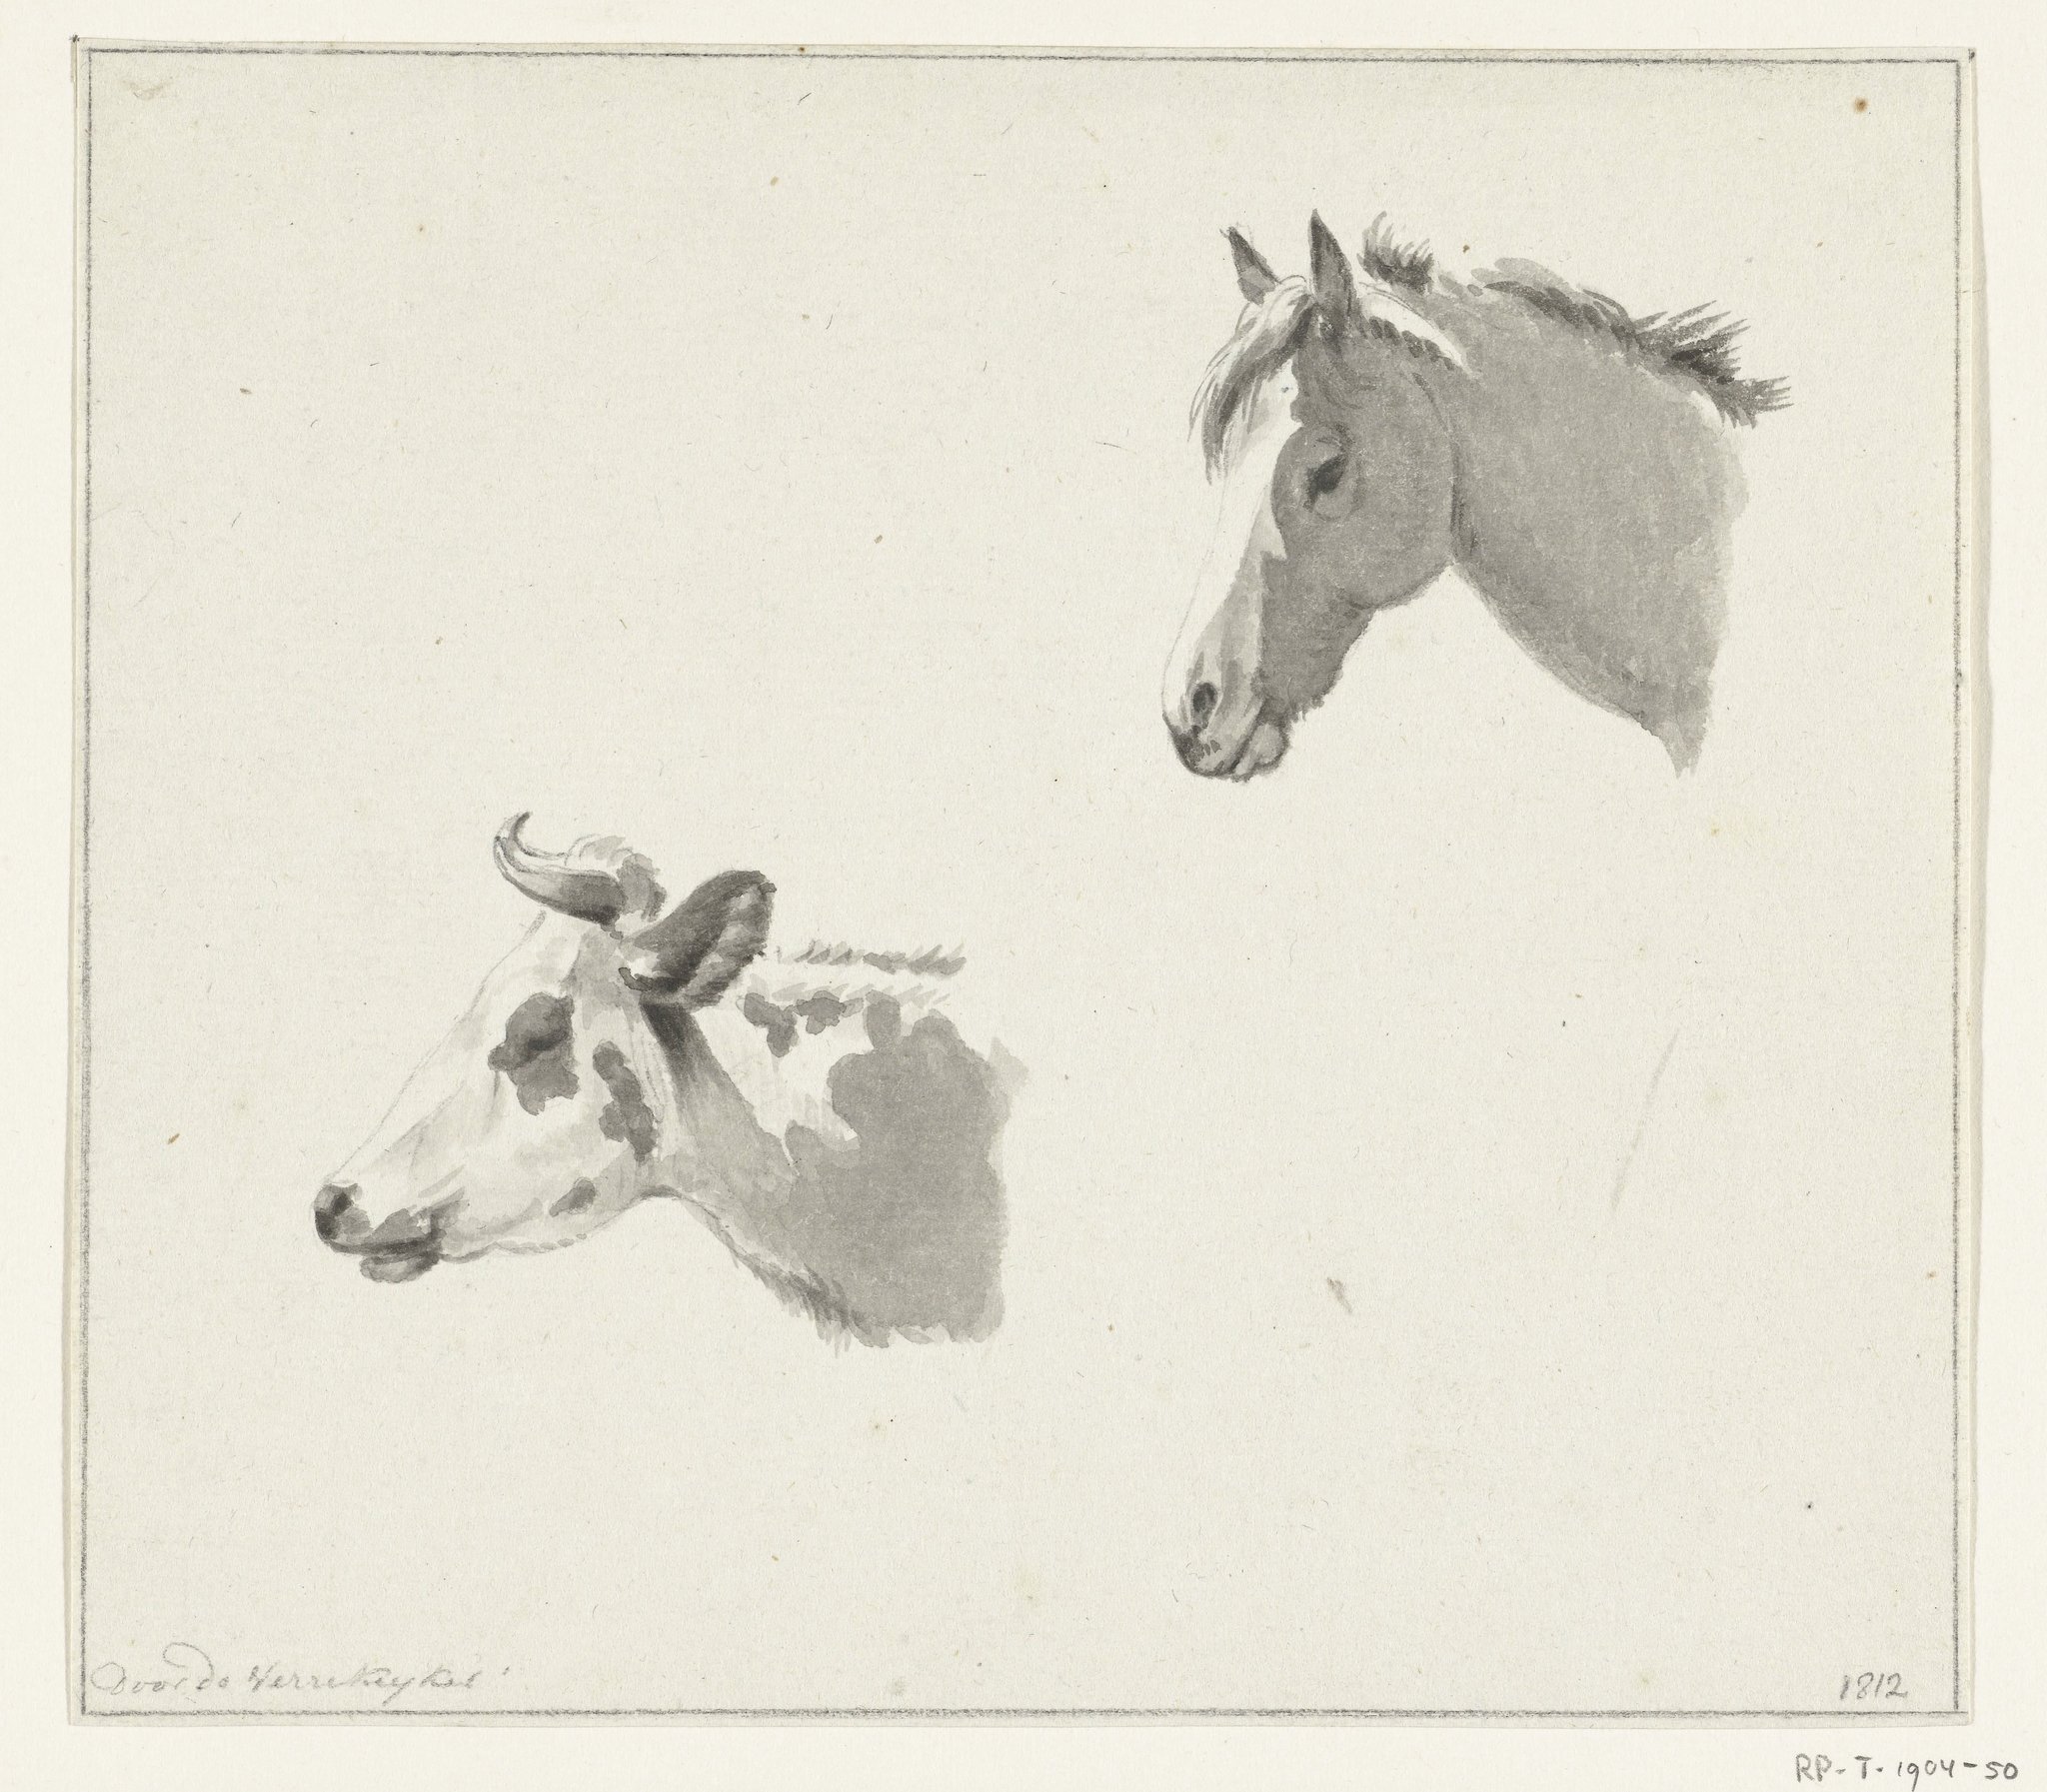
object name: drawing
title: Hoofd van een paard en de kop van een koe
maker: jean bernard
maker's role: draughtsman, print maker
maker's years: 1765-1833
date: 1812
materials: chalk, paper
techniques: brush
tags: cow, horse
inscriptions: : ‘door de verrekeyker’